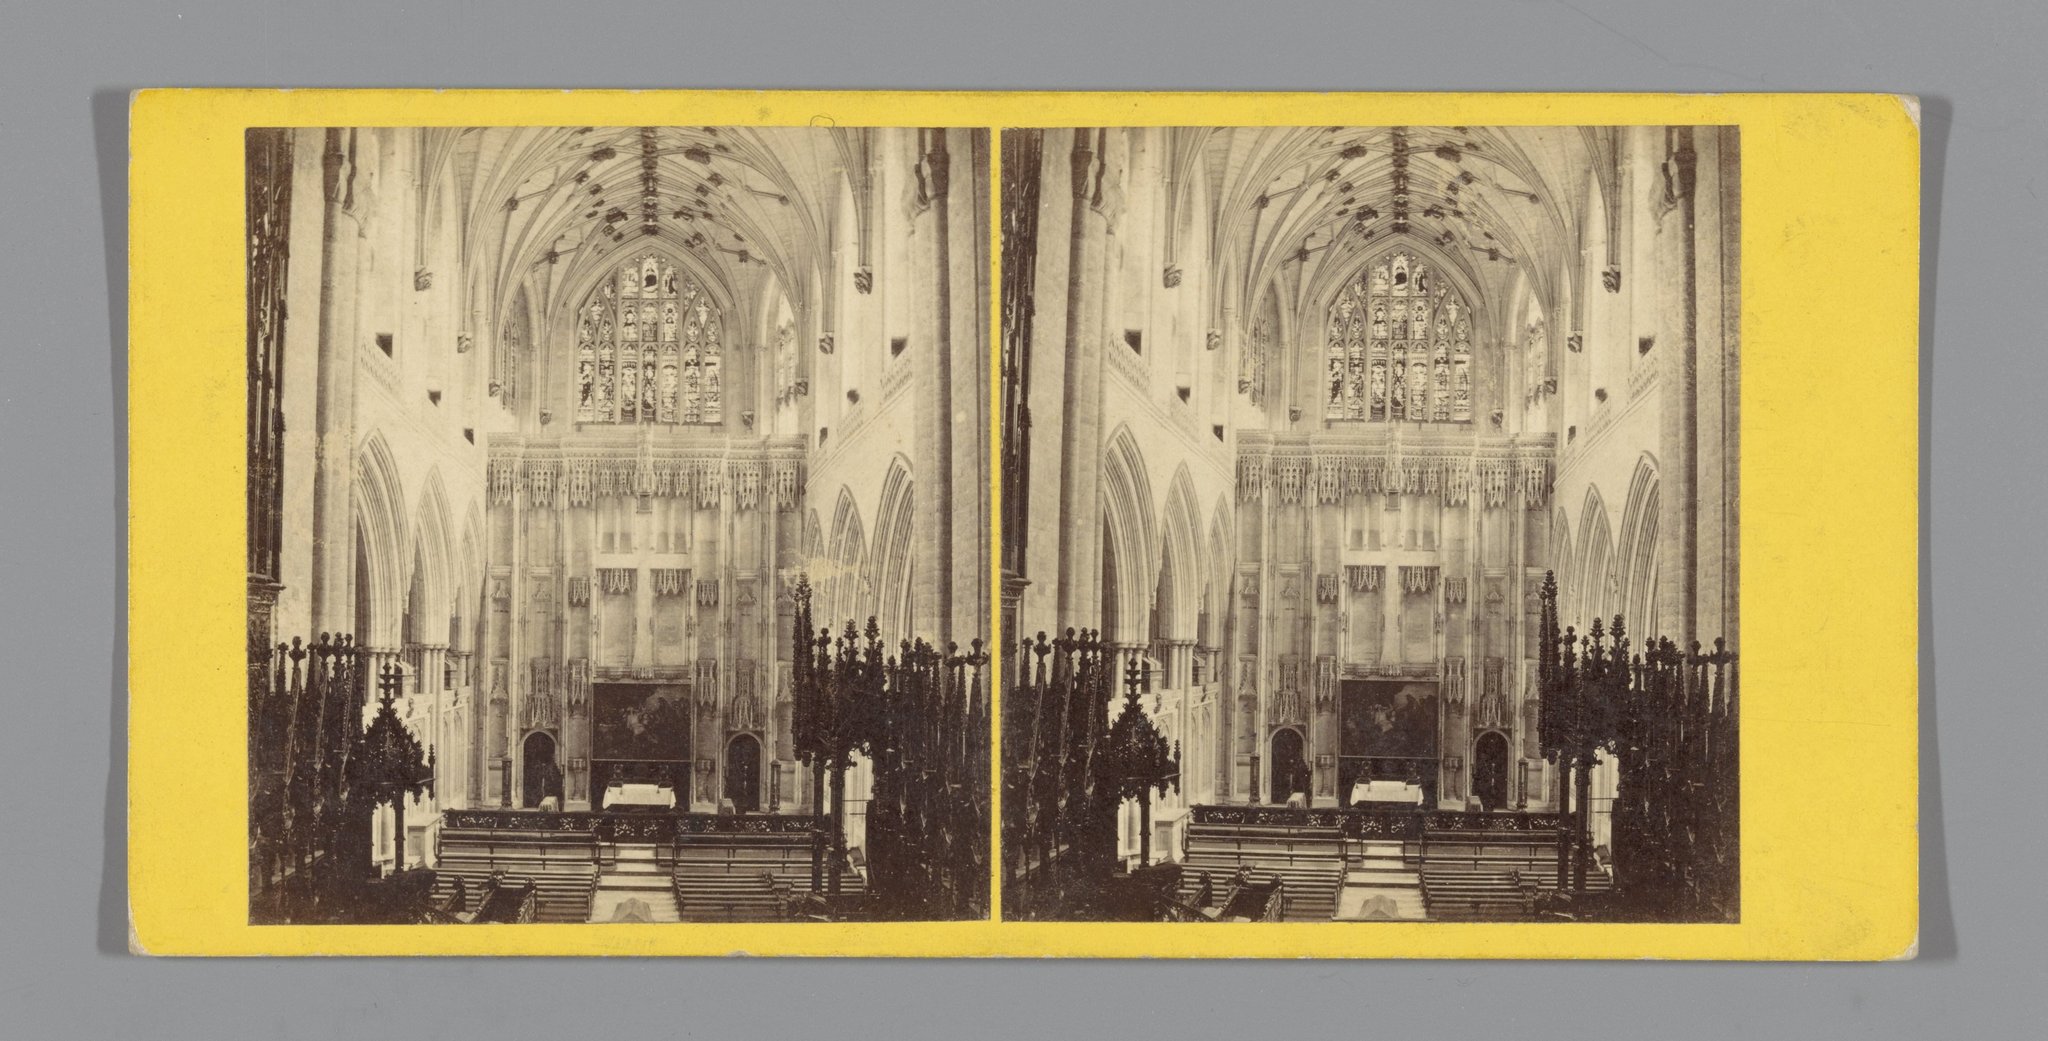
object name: stereograph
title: Winchester Cathedral-The Choir and Altar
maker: george washington wilson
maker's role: publisher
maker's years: 1823-1893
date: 1850-1880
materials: cardboard, photographic support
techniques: albumen print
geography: winchester cathedral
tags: parts of church interior: choir, winchester cathedral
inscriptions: name: ‘Registered G. W. Wilson, Photographer, Aberdeen.’, number: ‘No. 405.’